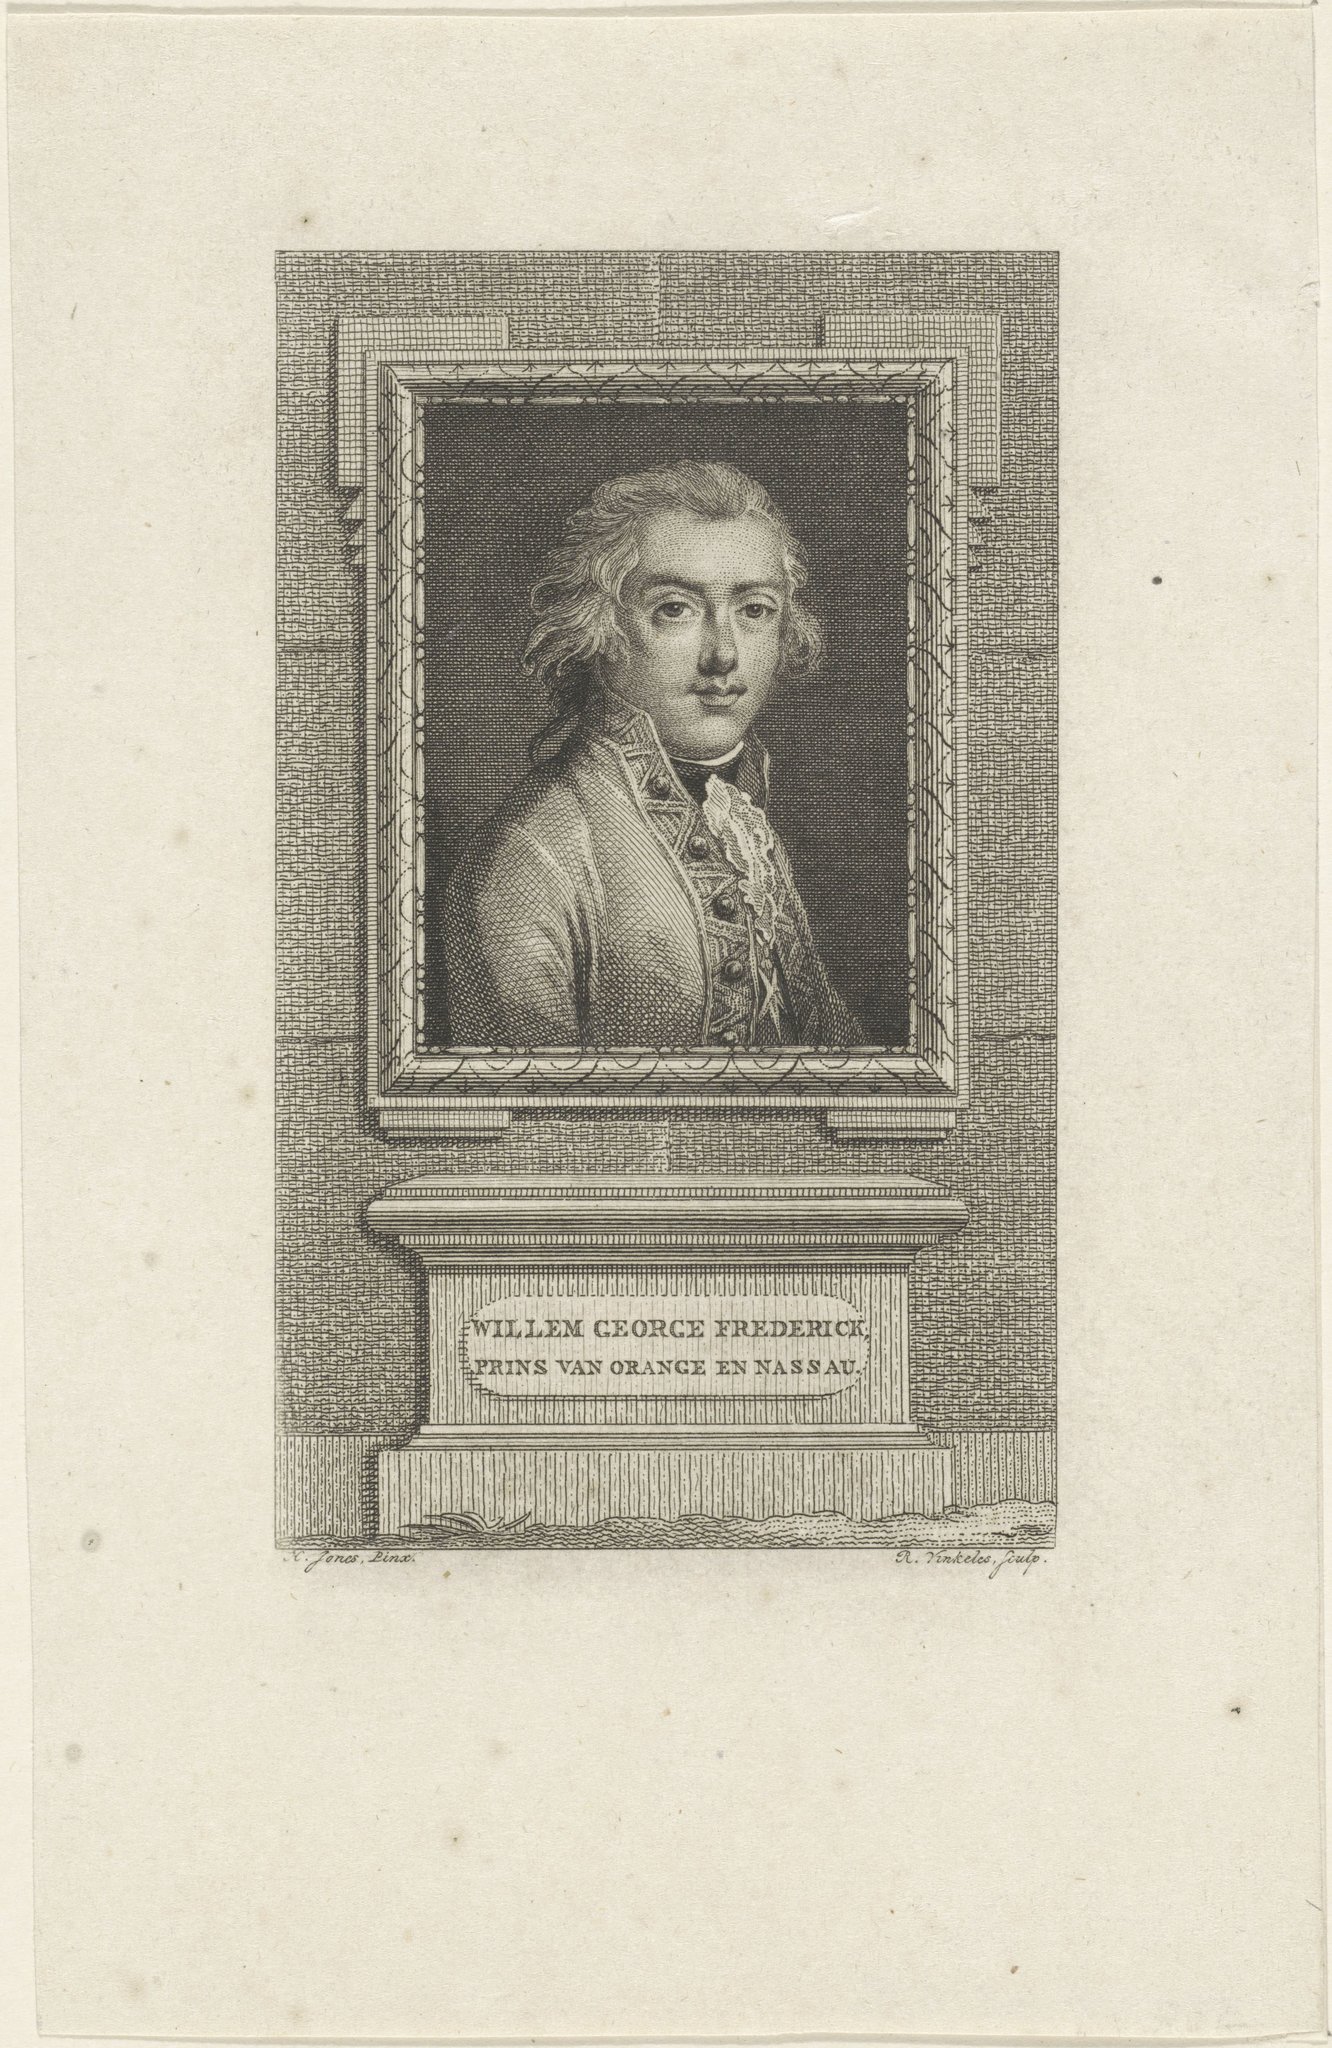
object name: print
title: Portret van Frederik, prins van Oranje-Nassau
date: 1790-1816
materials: paper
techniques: engraving, etching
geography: amsterdam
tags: the hague, willem george frederik (prins van oranje-nassau)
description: De hier vermelde titel verwijst naar de hoogst verkregen titel van de geportretteerde, niet per se naar de titel die de geportretteerde op deze voorstelling draagt.